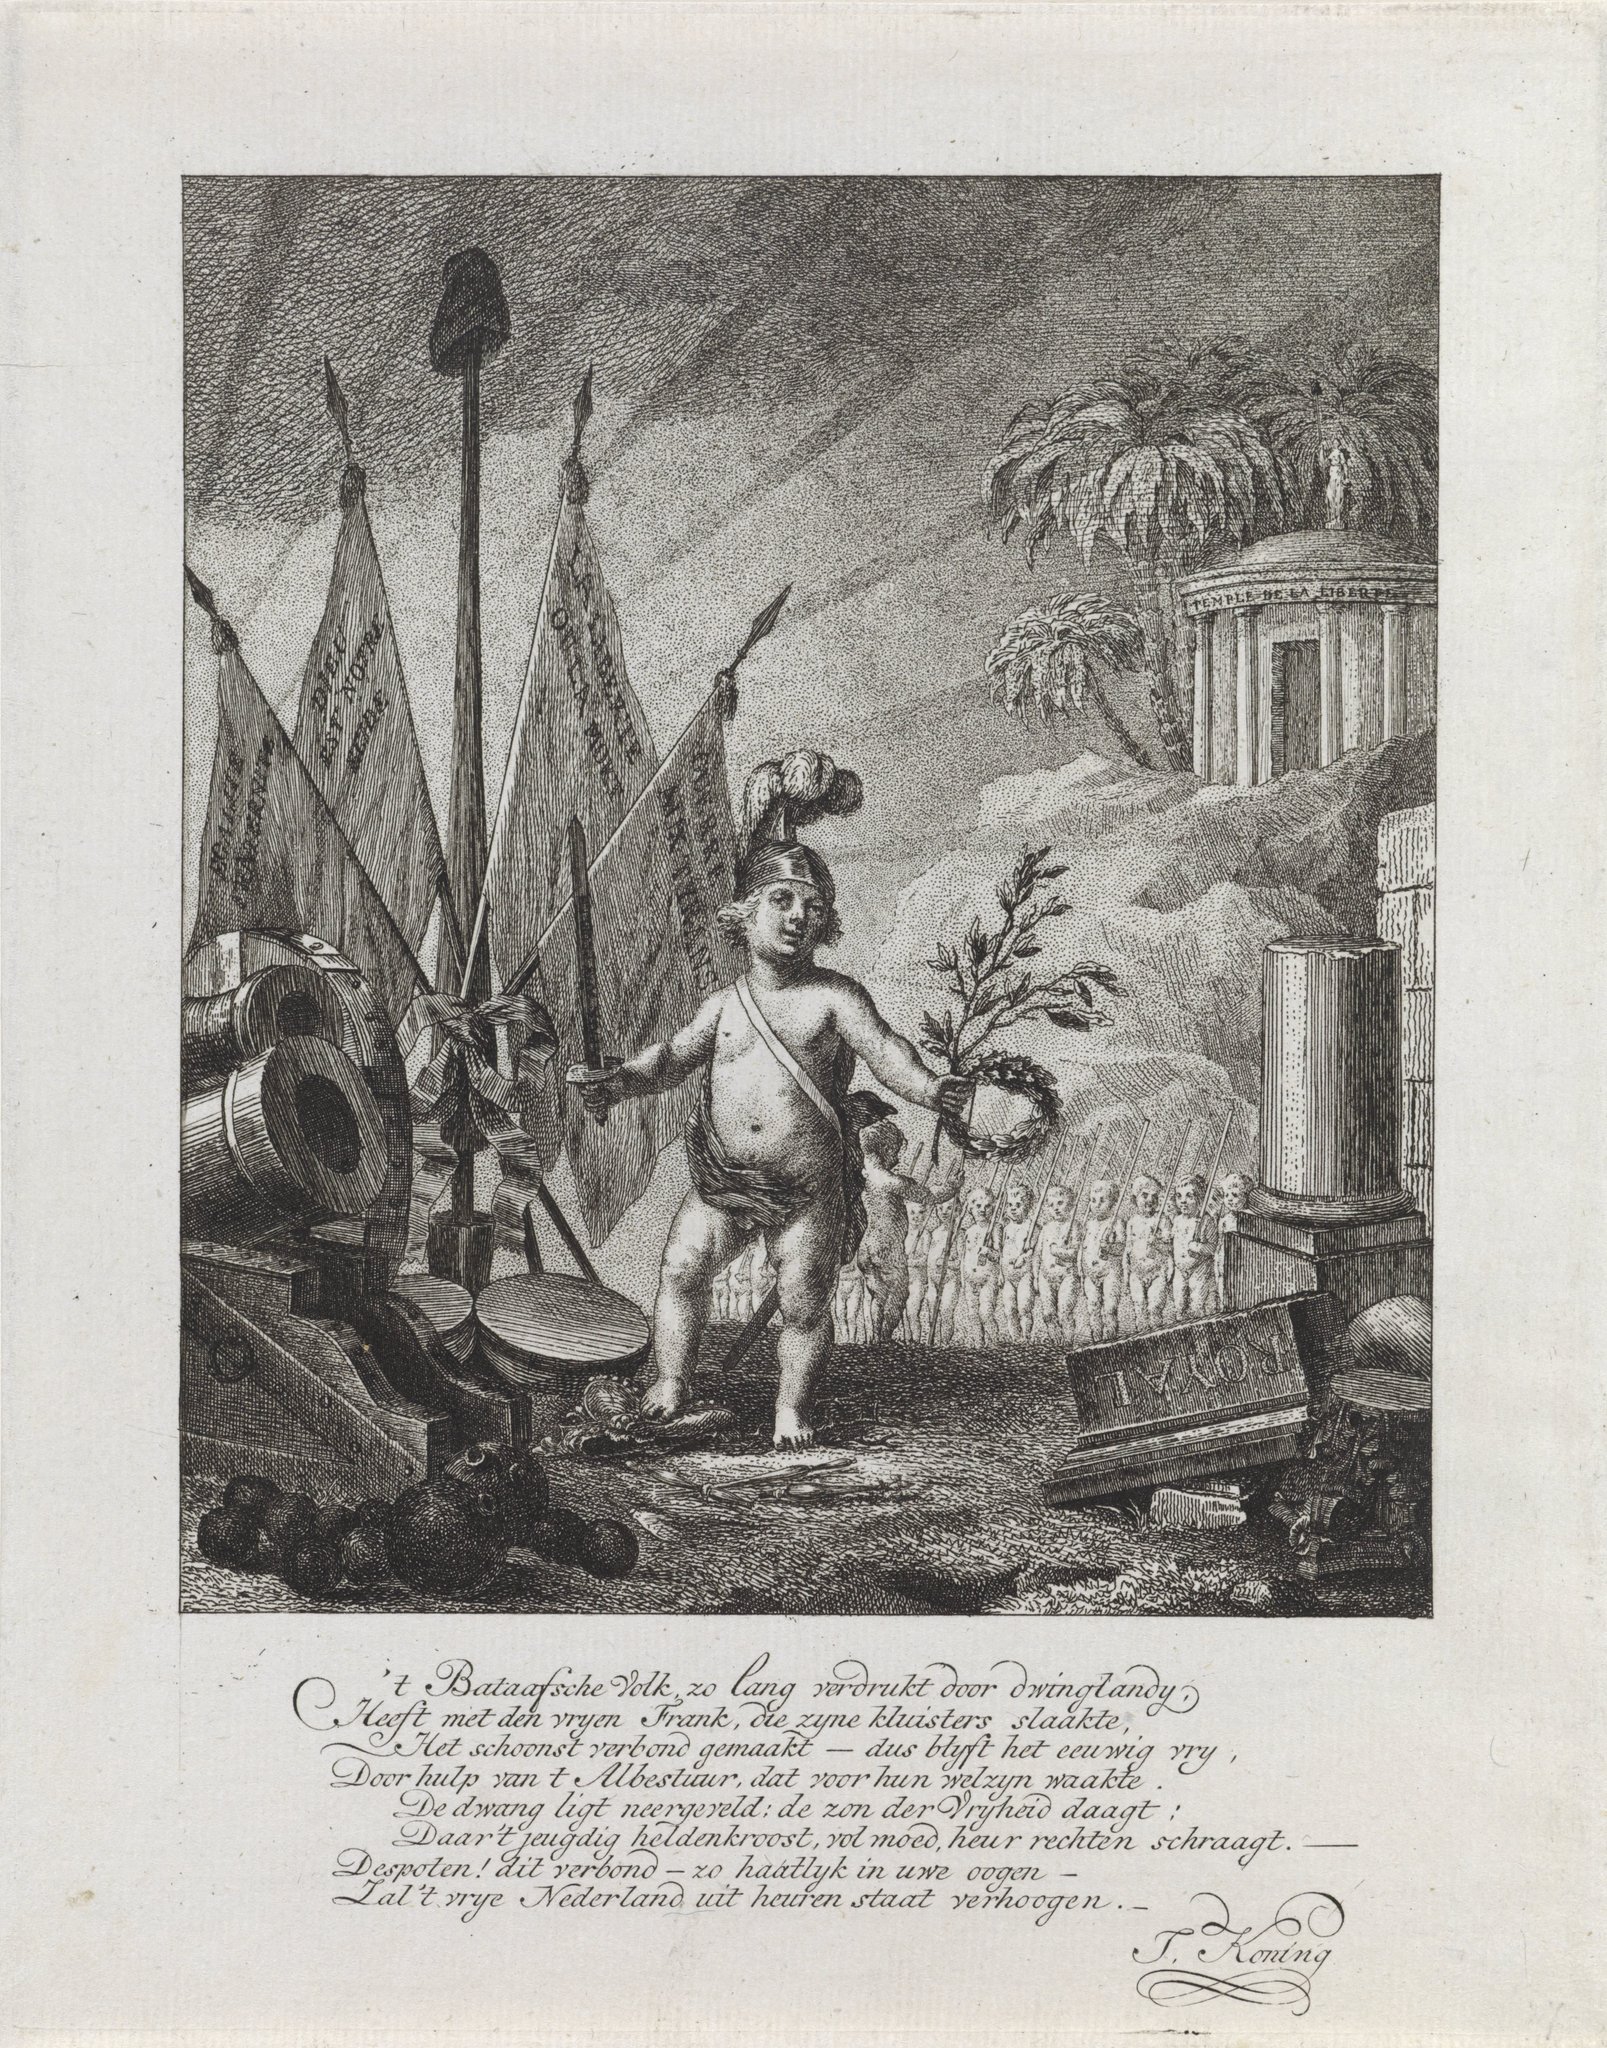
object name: print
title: Zinneprent op de Alliantie, 1795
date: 1795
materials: paper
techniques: engraving, etching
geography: netherlands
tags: 'tropaion', i.e. decorative ornament ~ weapons, freedom, liberty; 'libertà' (ripa) (+ symbolical representation of concept), alliance, league, union, foedus, alliance with france (1795)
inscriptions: collector's mark: Lugt 2228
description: Allegorie op de alliantie gesloten tussen de Franse en de Bataafse Republiek, 16 mei 1795. Een naakt kind, gewapend met zwaard en lauwerkrans en palmtak in de andere hand. Rechts ruïnes van het koningschap, op de achtergrond de tempel van de vrijheid. Links vaandels en wapens en de vrijheidslans met jacobijnenmuts. In de marge een vers van acht regels.